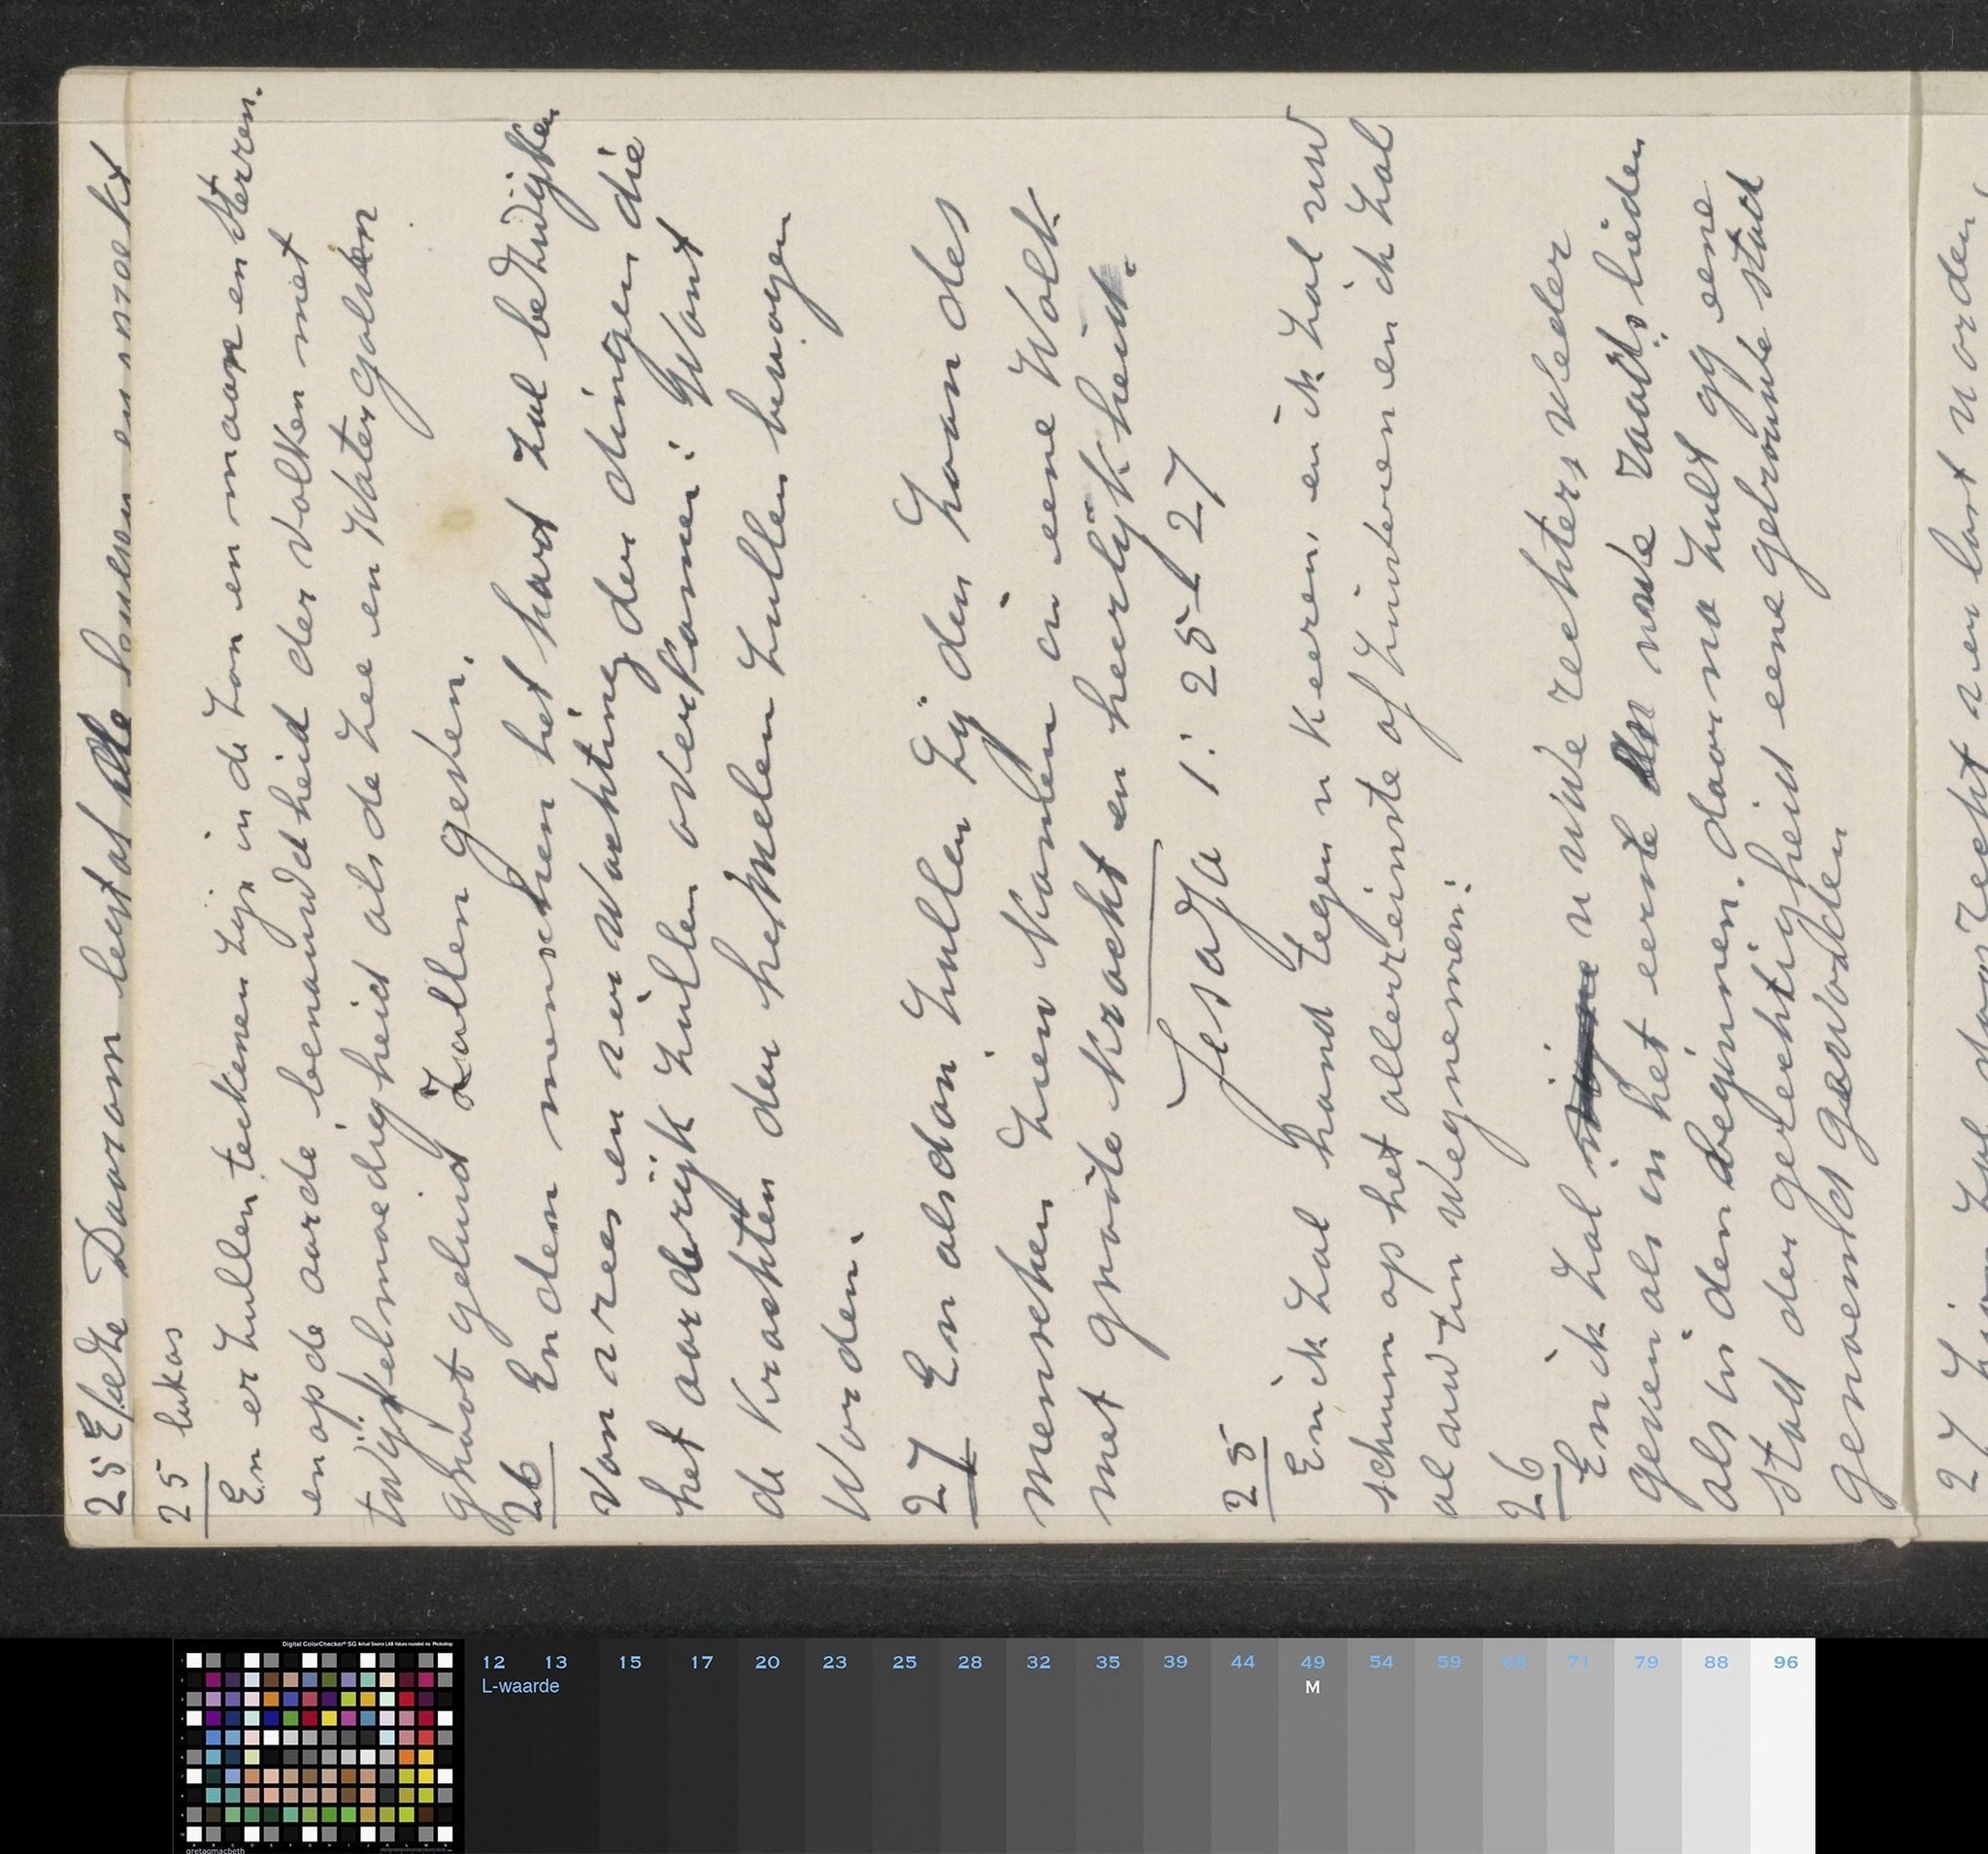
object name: sketchbook leaf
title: Bijbelverzen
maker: marie jordan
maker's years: 1866-1948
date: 1906-1948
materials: ink, paper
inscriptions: annotation: ‘[...]’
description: Pagina 17 uit een schetsboek met 31 bladen.